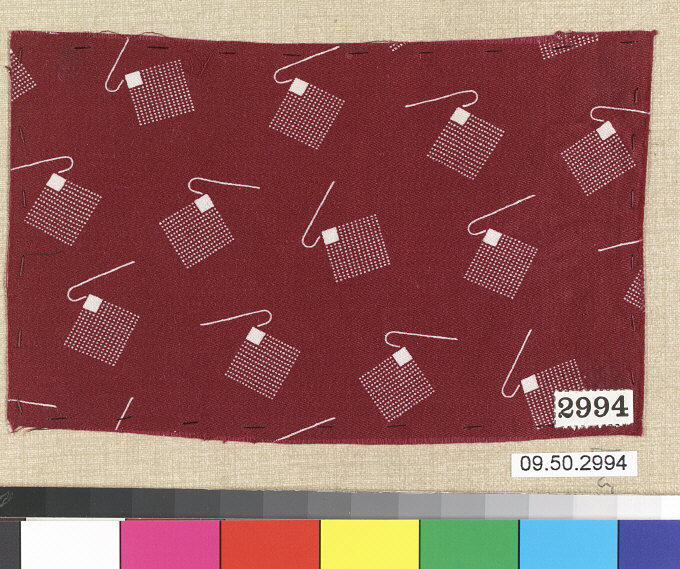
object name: piece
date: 1801-1900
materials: cotton